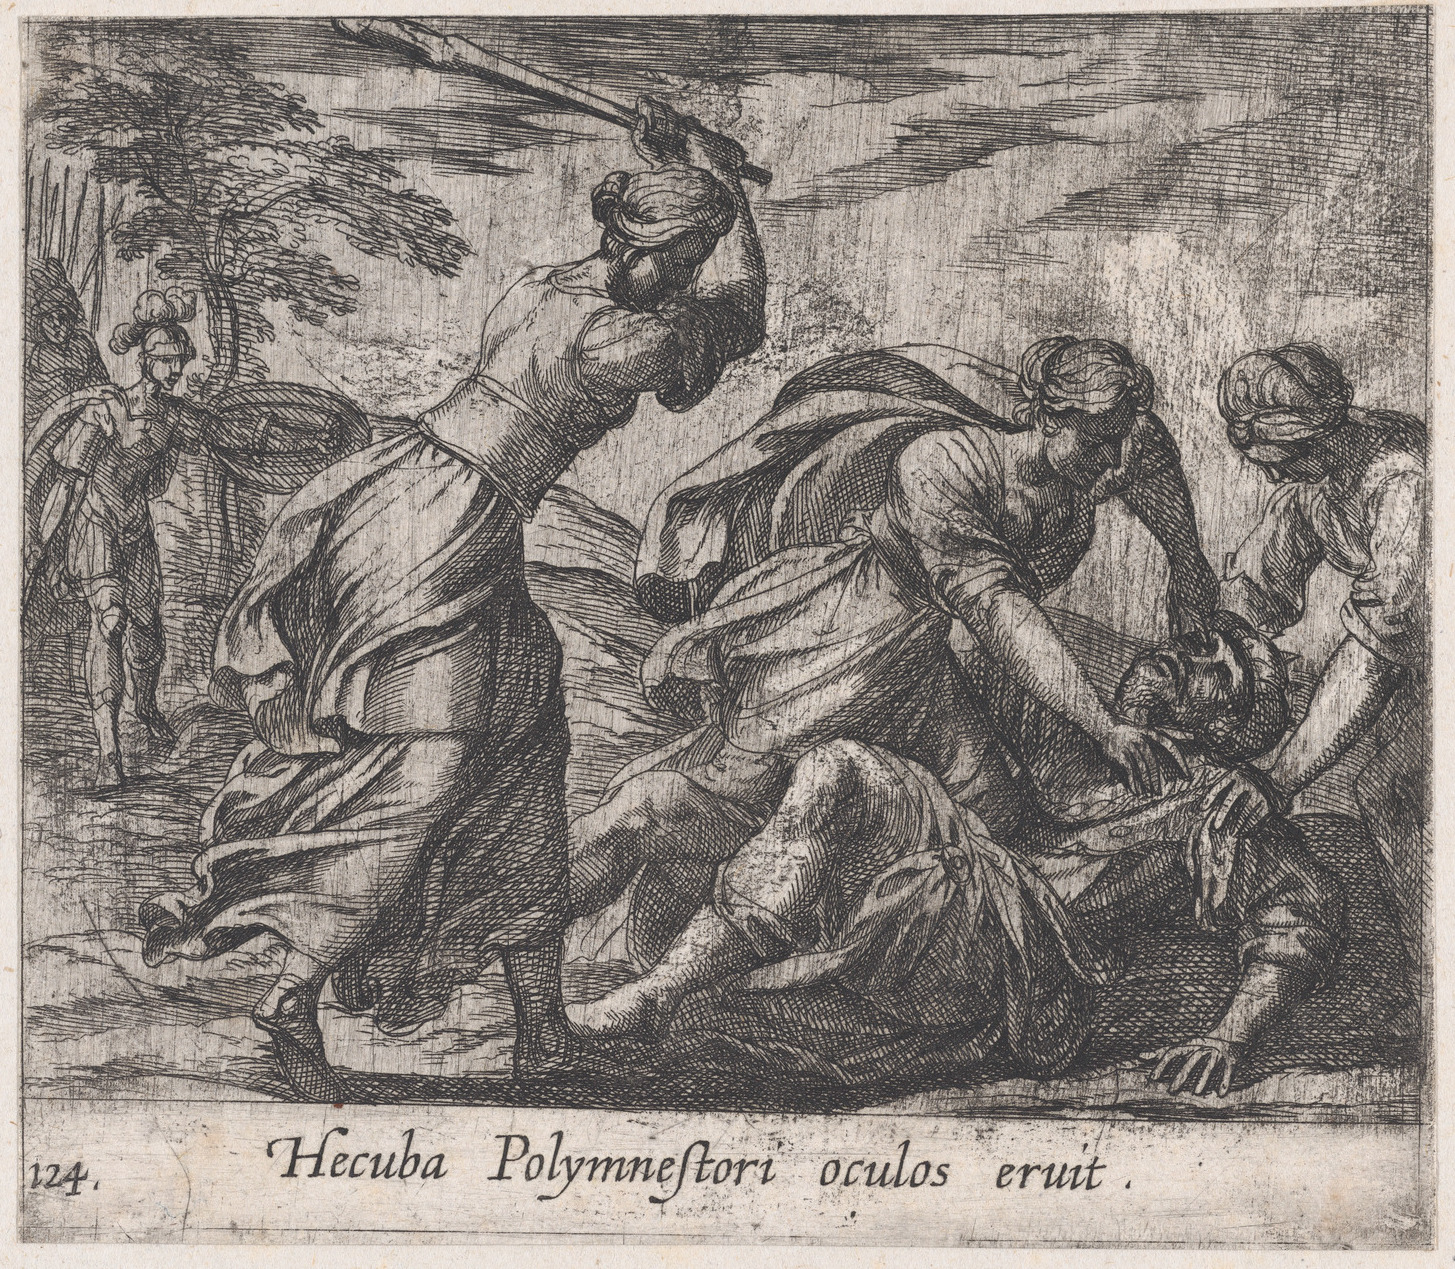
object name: print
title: Plate 124: Hecuba and the Trojan Women Murdering Polymestor (Hecuba Polymnestori oculos ervit), from Ovid's 'Metamorphoses'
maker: antonio tempesta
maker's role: artist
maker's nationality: italian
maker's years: 1555-1630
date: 1606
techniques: etching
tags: ovid,men,women